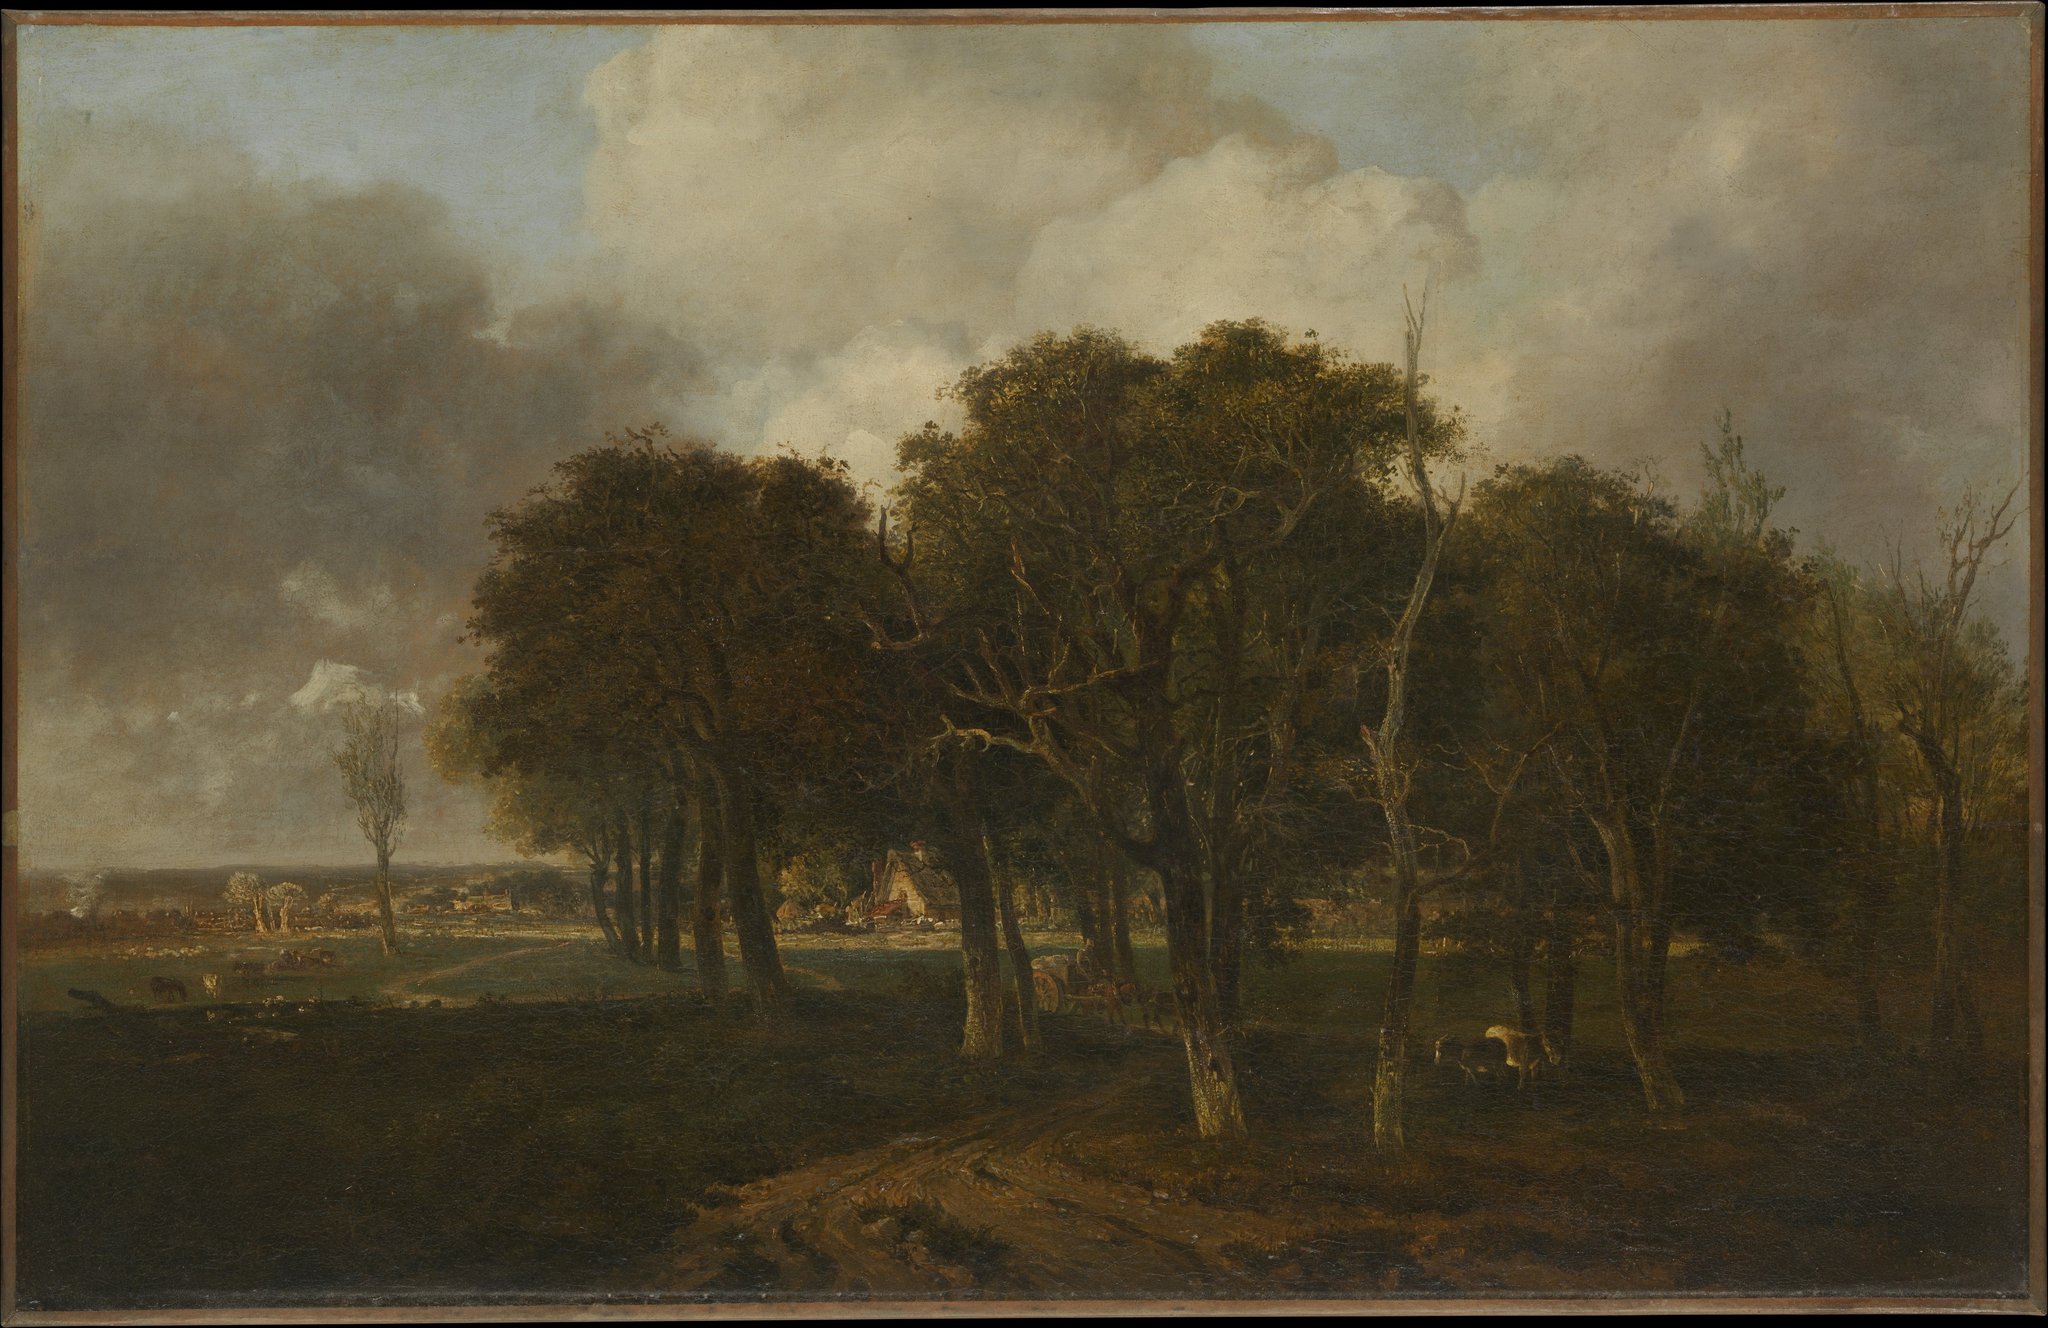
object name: painting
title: Hautbois Common, Norfolk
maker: john crome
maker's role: artist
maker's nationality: british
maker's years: 1768-1821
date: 1810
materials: canvas, oil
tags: landscapes,trees,clouds